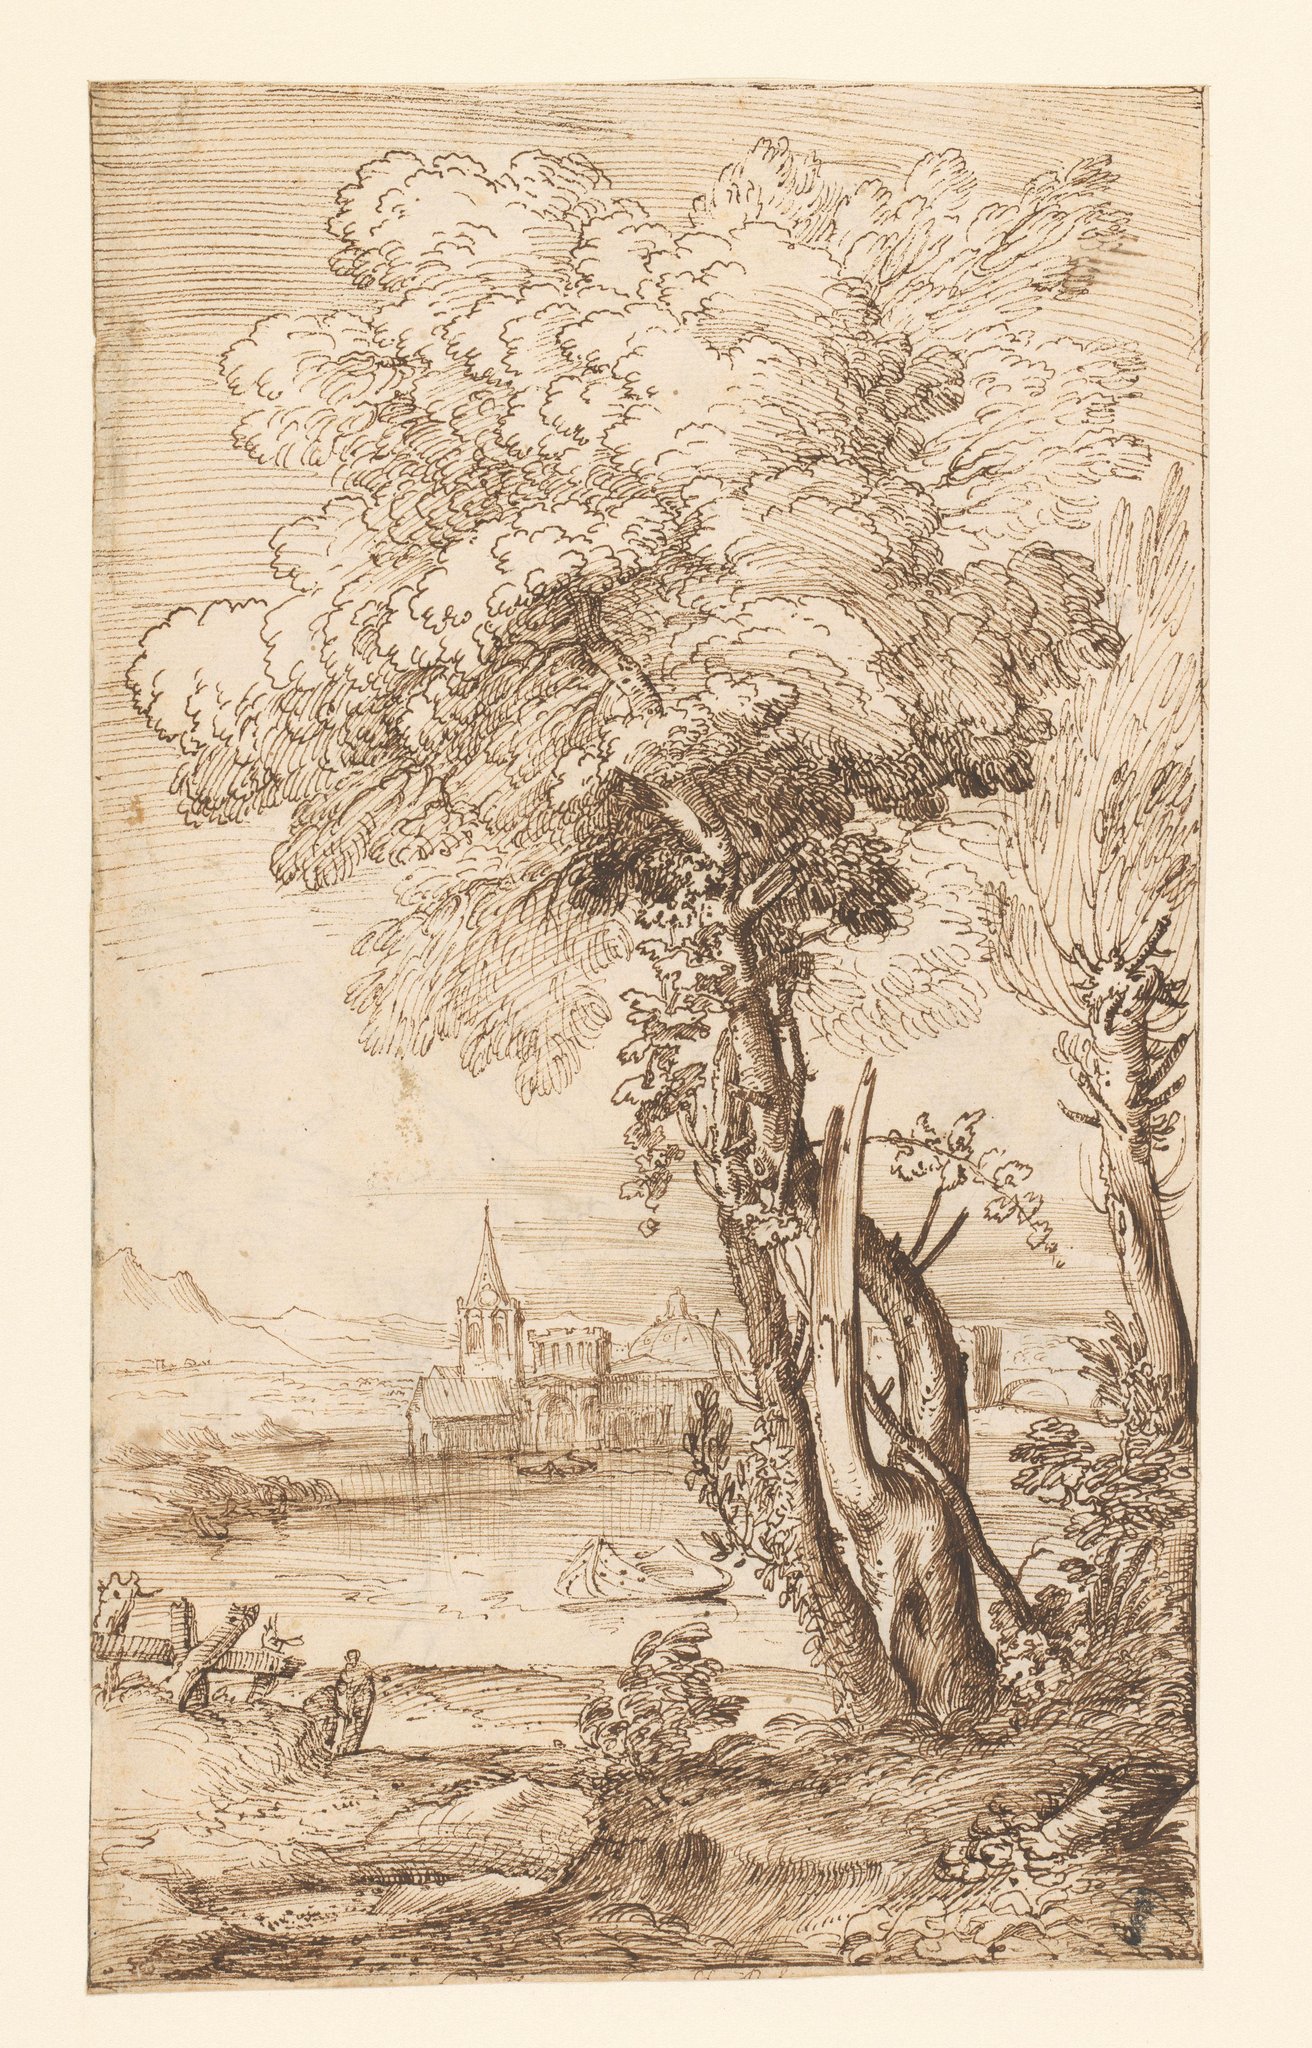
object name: drawing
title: Boomgroep aan een meer in een bergachtig landschap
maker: giovanni francesco grimaldi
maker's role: draughtsman, print maker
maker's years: 1606-1680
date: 1652-1662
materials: ink, paper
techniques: pen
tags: lake, groups of trees